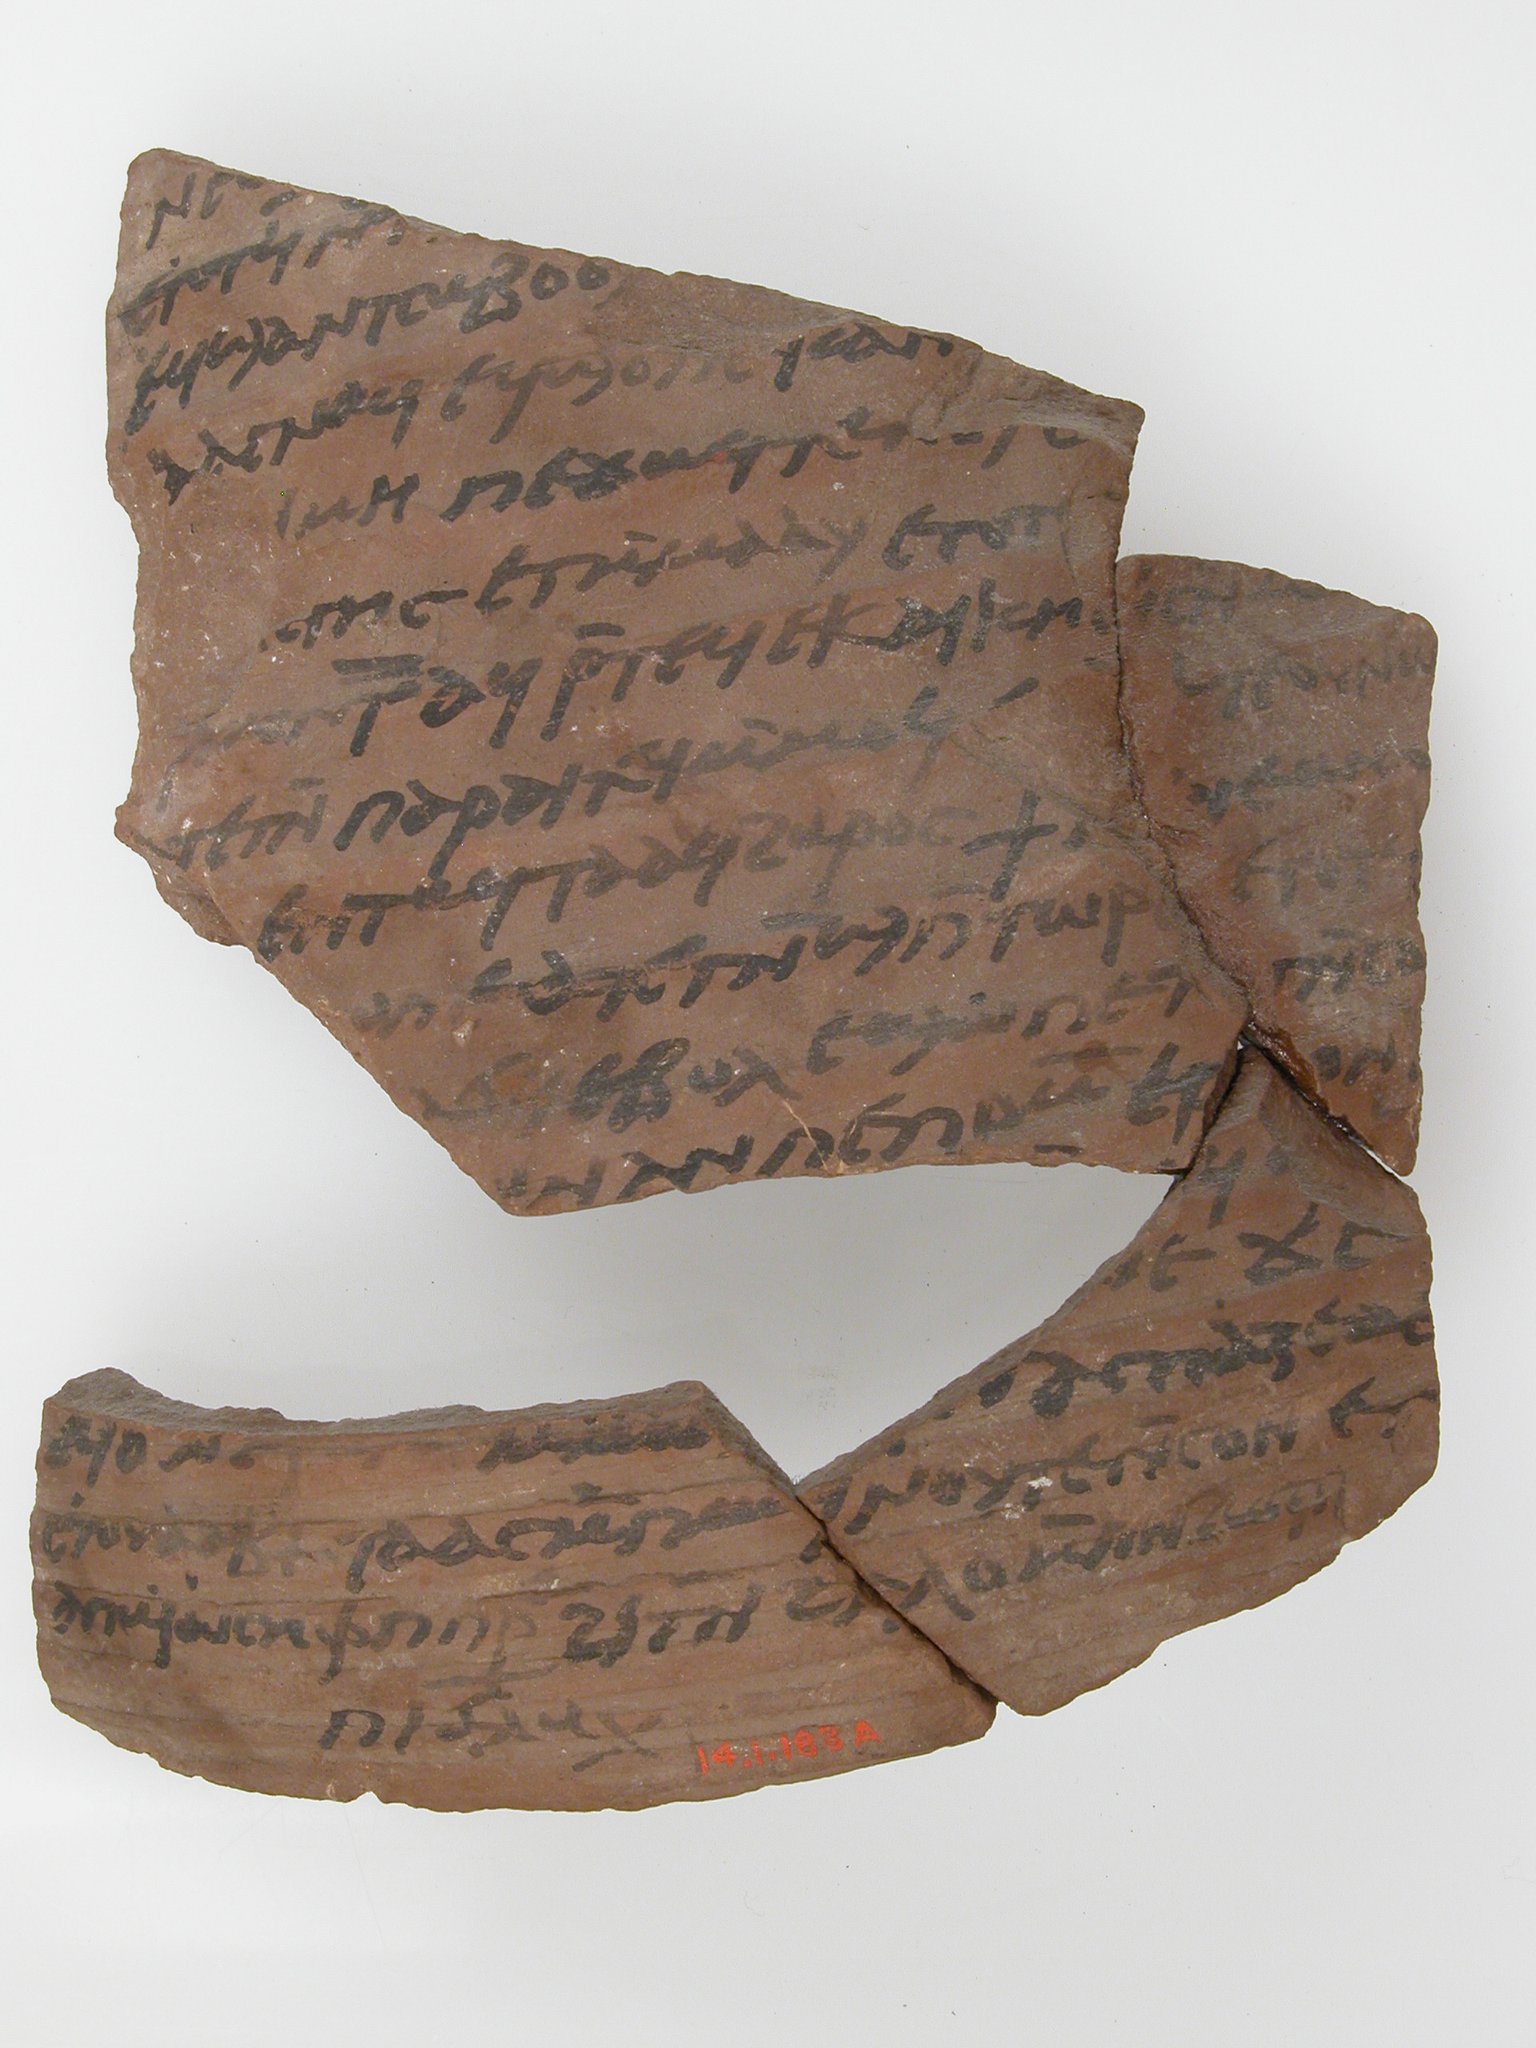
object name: ostrakon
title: Ostrakon with a Letter from Hello to Joseph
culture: coptic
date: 580-640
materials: ink, pottery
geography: egypt